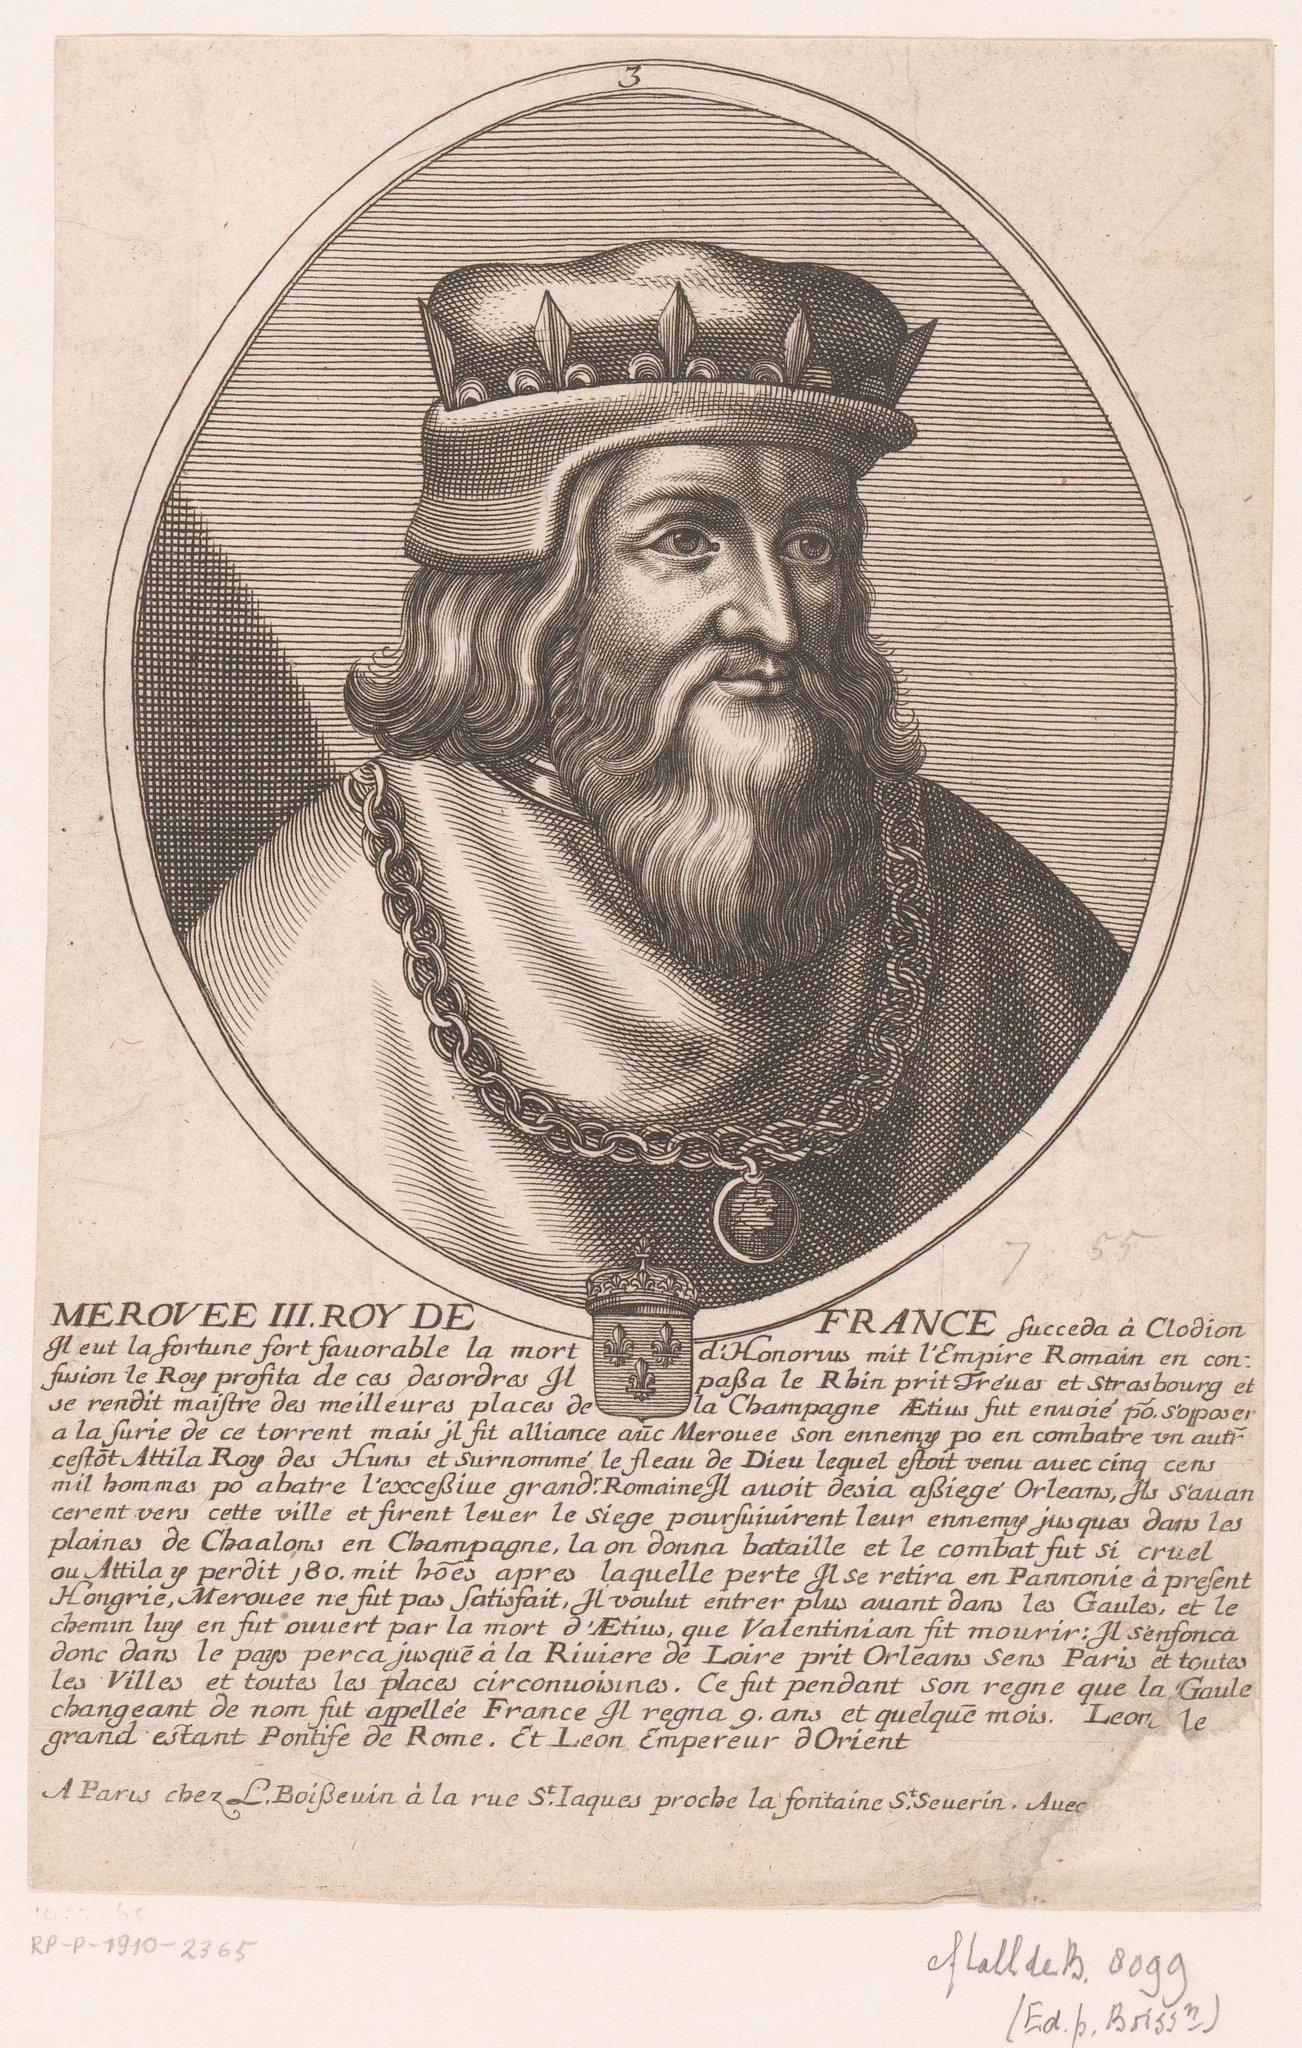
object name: print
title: Portret van Merovech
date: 1633-1676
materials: paper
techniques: engraving, etching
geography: france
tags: ornament ~ medallion, historical persons, ruler, sovereign, armorial bearing, heraldry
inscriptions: collector's mark: Lugt 2228